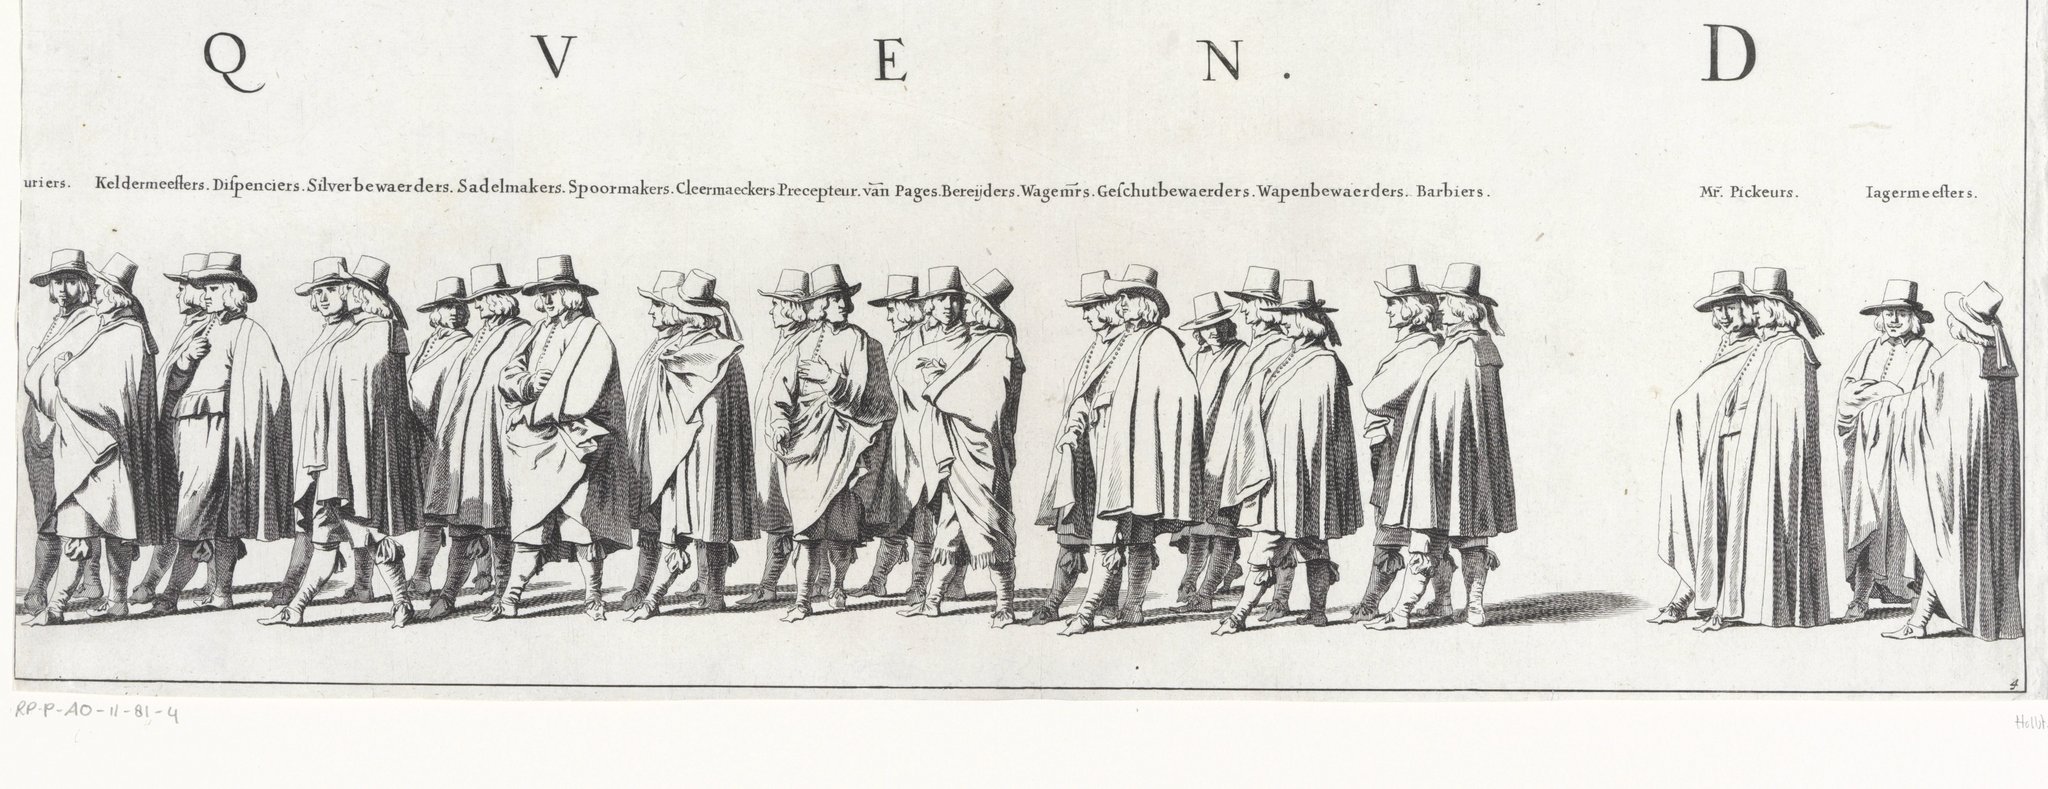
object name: print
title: De begrafenisstoet van Frederik Hendrik (plaat nr. 4), 1647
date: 1651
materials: paper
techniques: engraving, etching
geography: amsterdam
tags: cortege, funeral procession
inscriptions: collector's mark: Lugt 2228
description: De begrafenisstoet van stadhouder Frederik Hendrik te 's-Gravenhage op 10 mei 1647. Plaat nr. 4 met een deel van de stoet, boven de personen staat hun functie. Onderdeel van een serie van 30 platen en 20 tekstbladen, bedoeld om aan elkaar geplakt te worden.